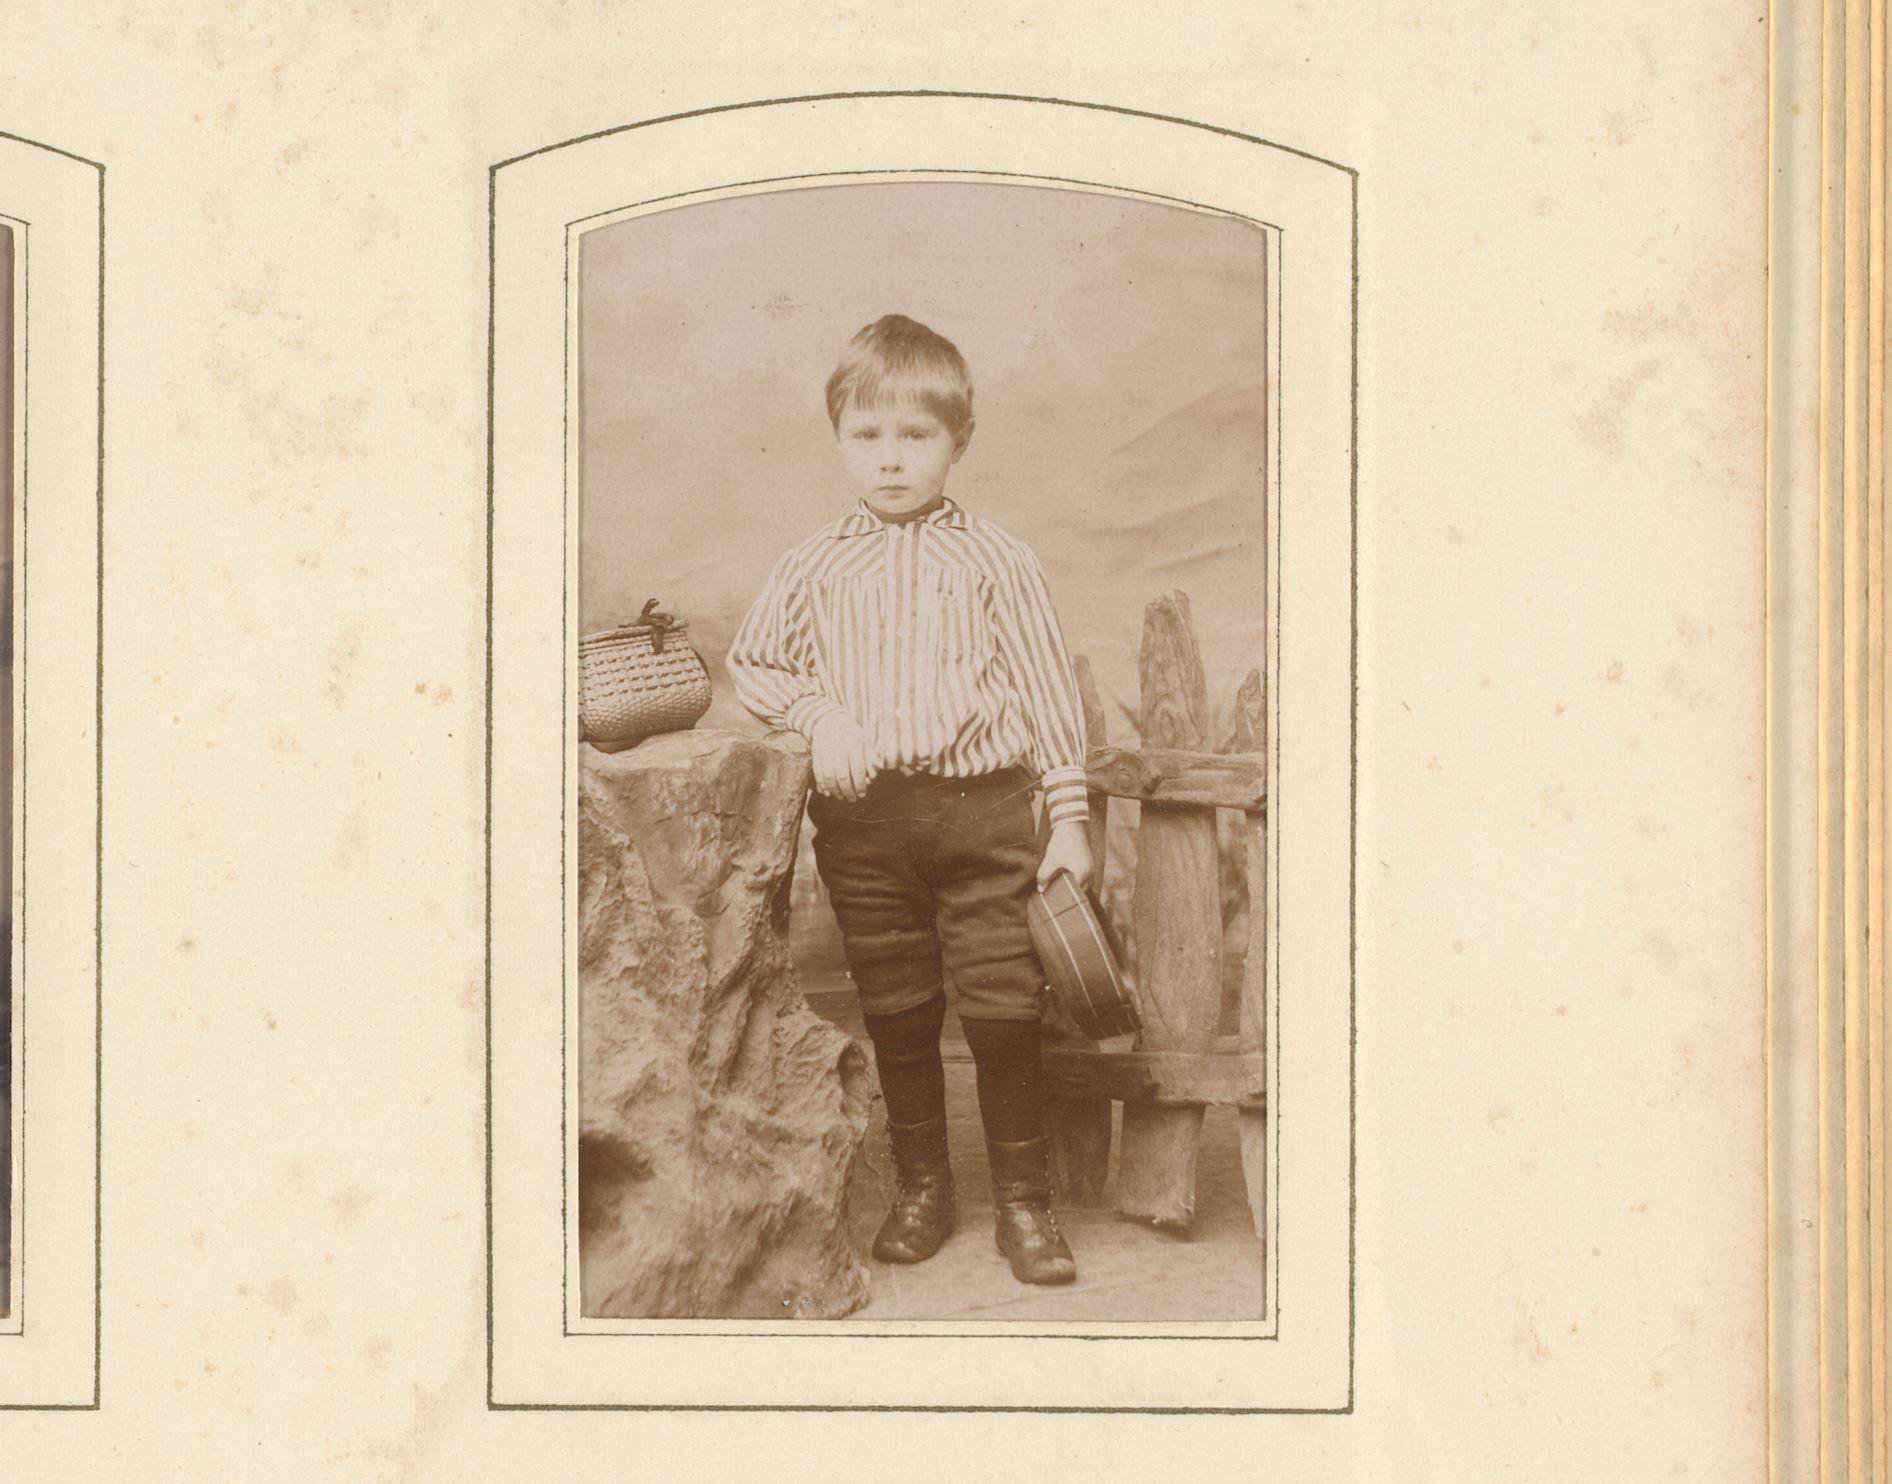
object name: carte de visite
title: Portret van een jongen met pet in de hand, staand in een decor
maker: friedrich carel hisgen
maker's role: fotograaf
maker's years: 1846-1912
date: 1891-1912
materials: cardboard, photographic support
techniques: collodion silver print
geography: amsterdam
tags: boy (child between toddler and youth), historical persons, head-gear: cap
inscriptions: inscription: ‘American Photography/ F. Hisgen/ Amsterdam, P.C. Hooftstraat 72/ Atelier gelijkvloers’